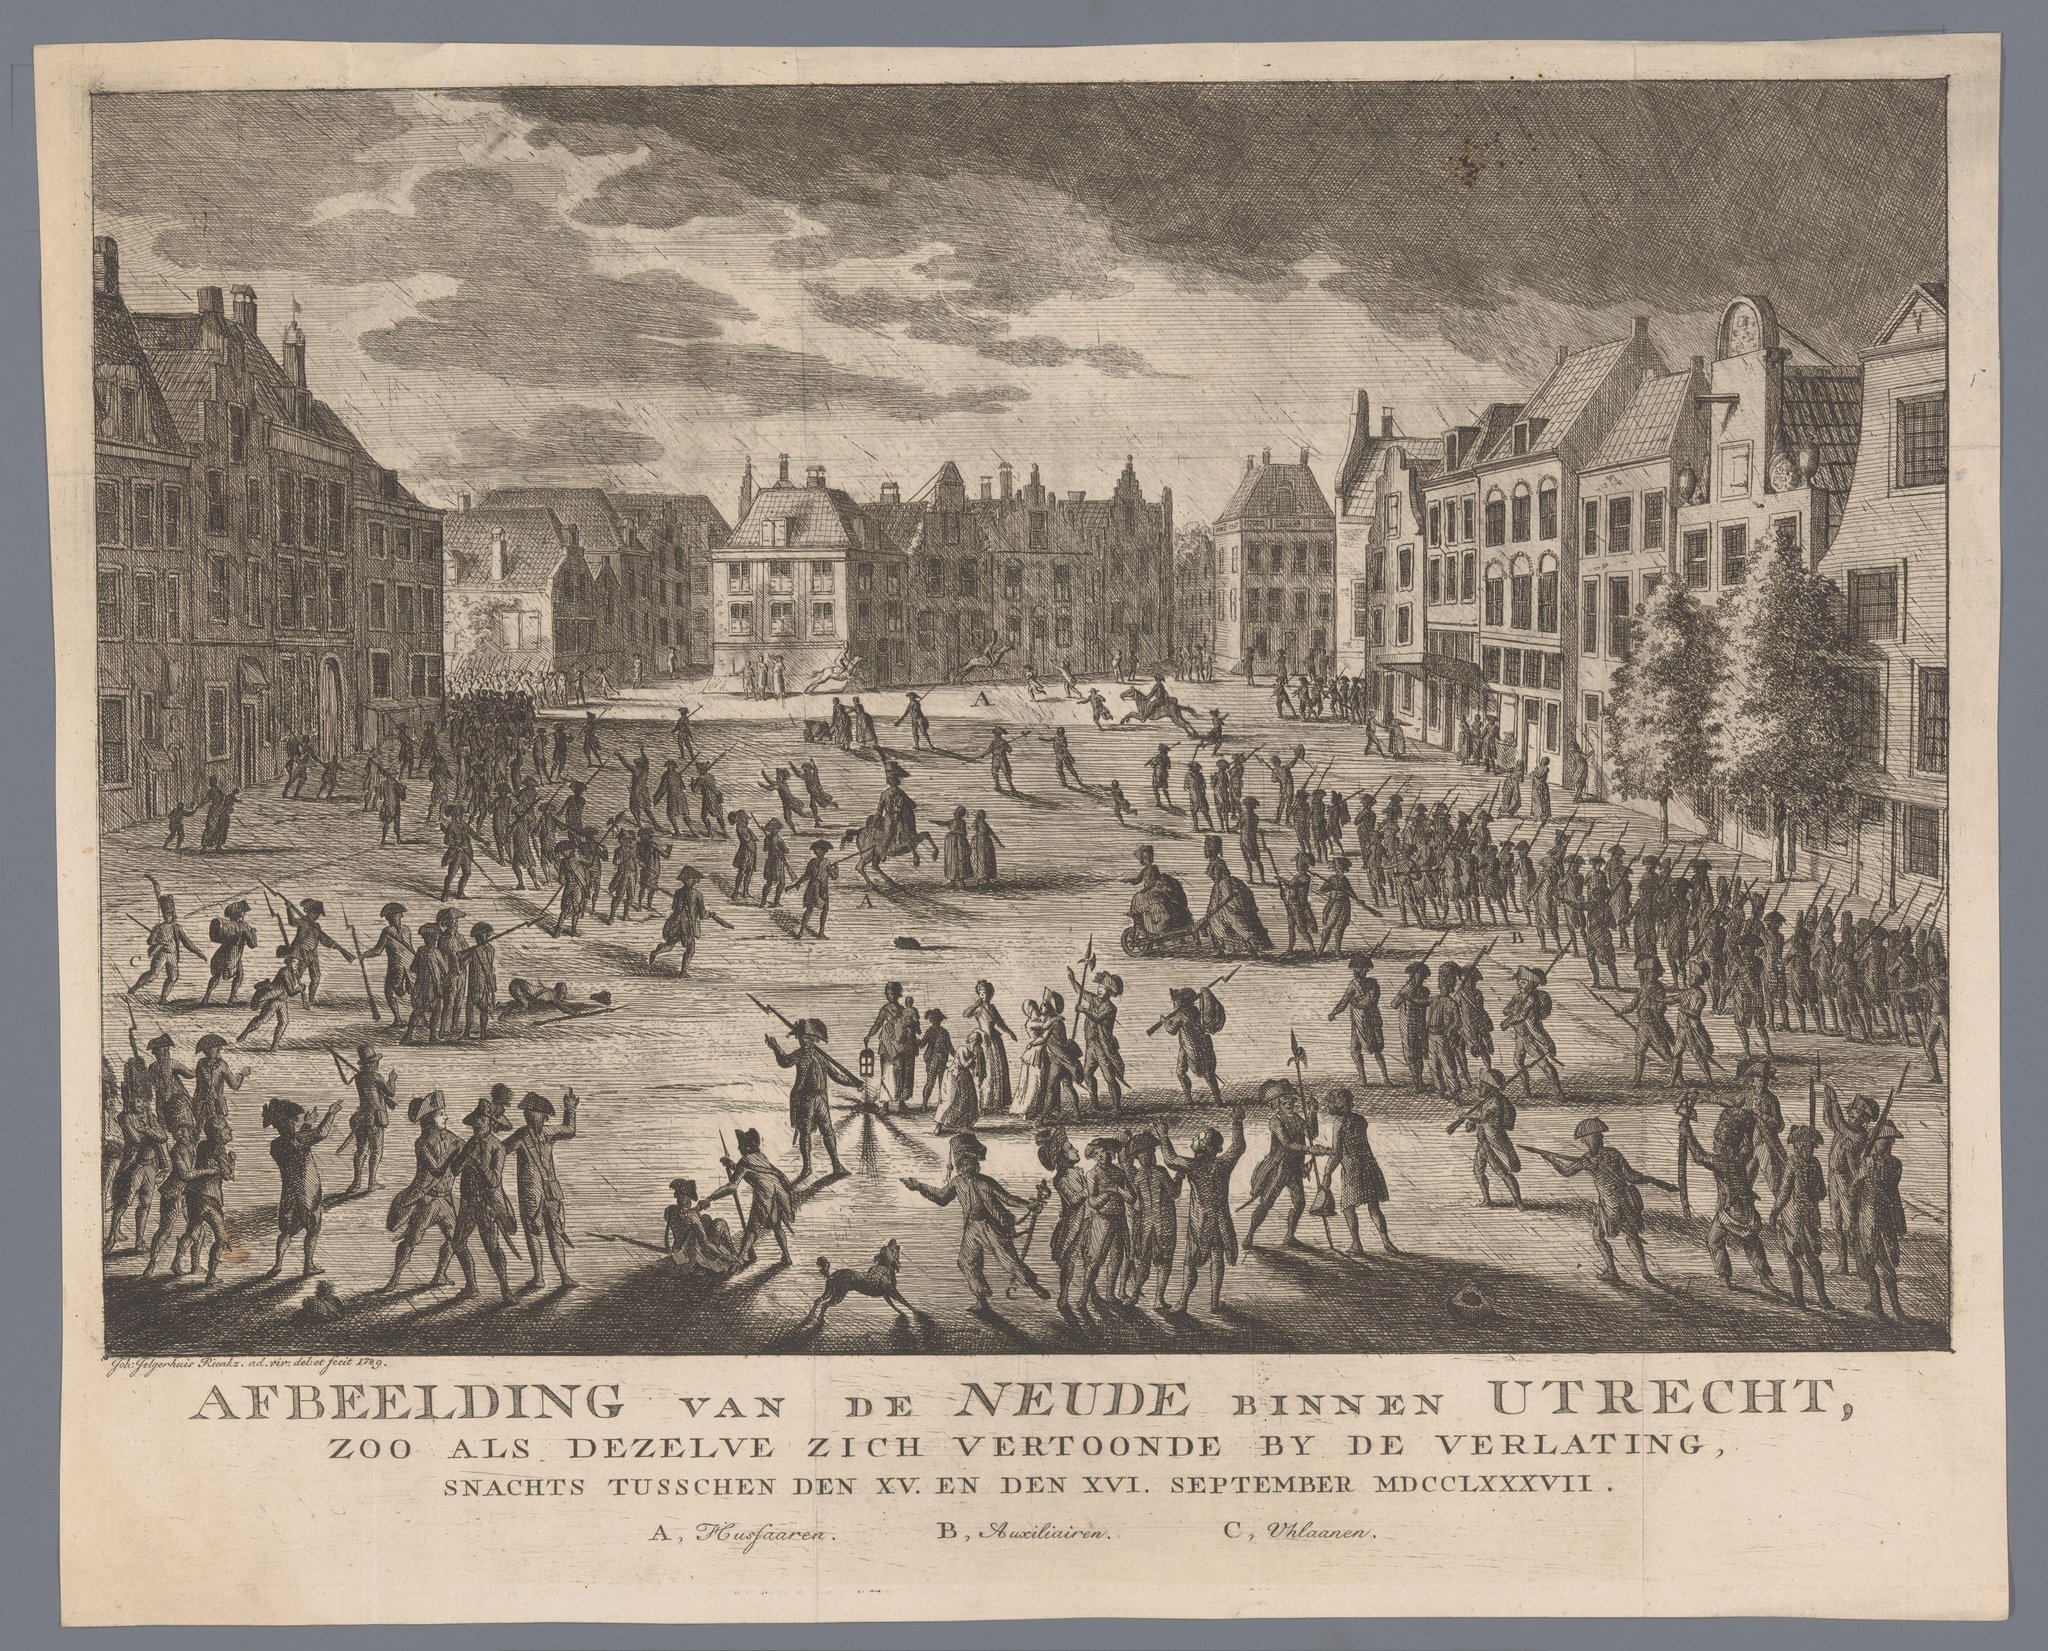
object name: print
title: Patriotten verlaten de Neude te Utrecht, 1787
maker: johannes jelgerhuis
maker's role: draughtsman, painter, print maker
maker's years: 1770-1836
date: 1789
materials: paper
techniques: etching, intaglio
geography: utrecht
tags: putting the enemy to flight - hh - being put to flight, fleeing (+ citizen soldiery, civil guard, citizen militia), square, place, circus, etc. (+ city(-scape) with figures, staffage)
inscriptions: collector's mark: Lugt 2233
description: Chaos op de Neude te Utrecht in de nacht van 15 op 16 september 1787 als de patriotse schutterijen het plein en de stad ontvluchten wegens de naderende Pruisische troepen.